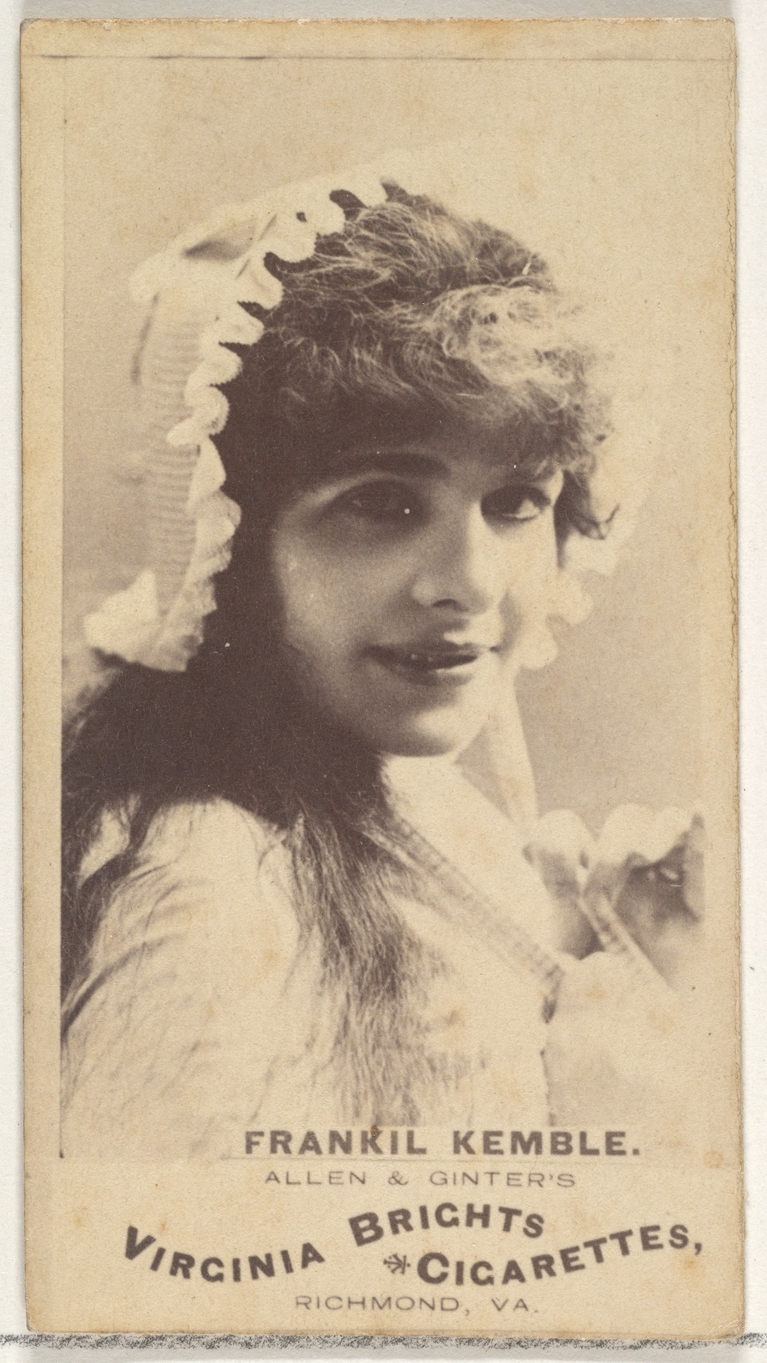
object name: photograph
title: Frankil Kemble, from the Actors and Actresses series (N45, Type 1) for Virginia Brights Cigarettes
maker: allen & ginter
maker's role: publisher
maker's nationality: american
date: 1888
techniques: albumen silver print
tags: portraits,women,actresses